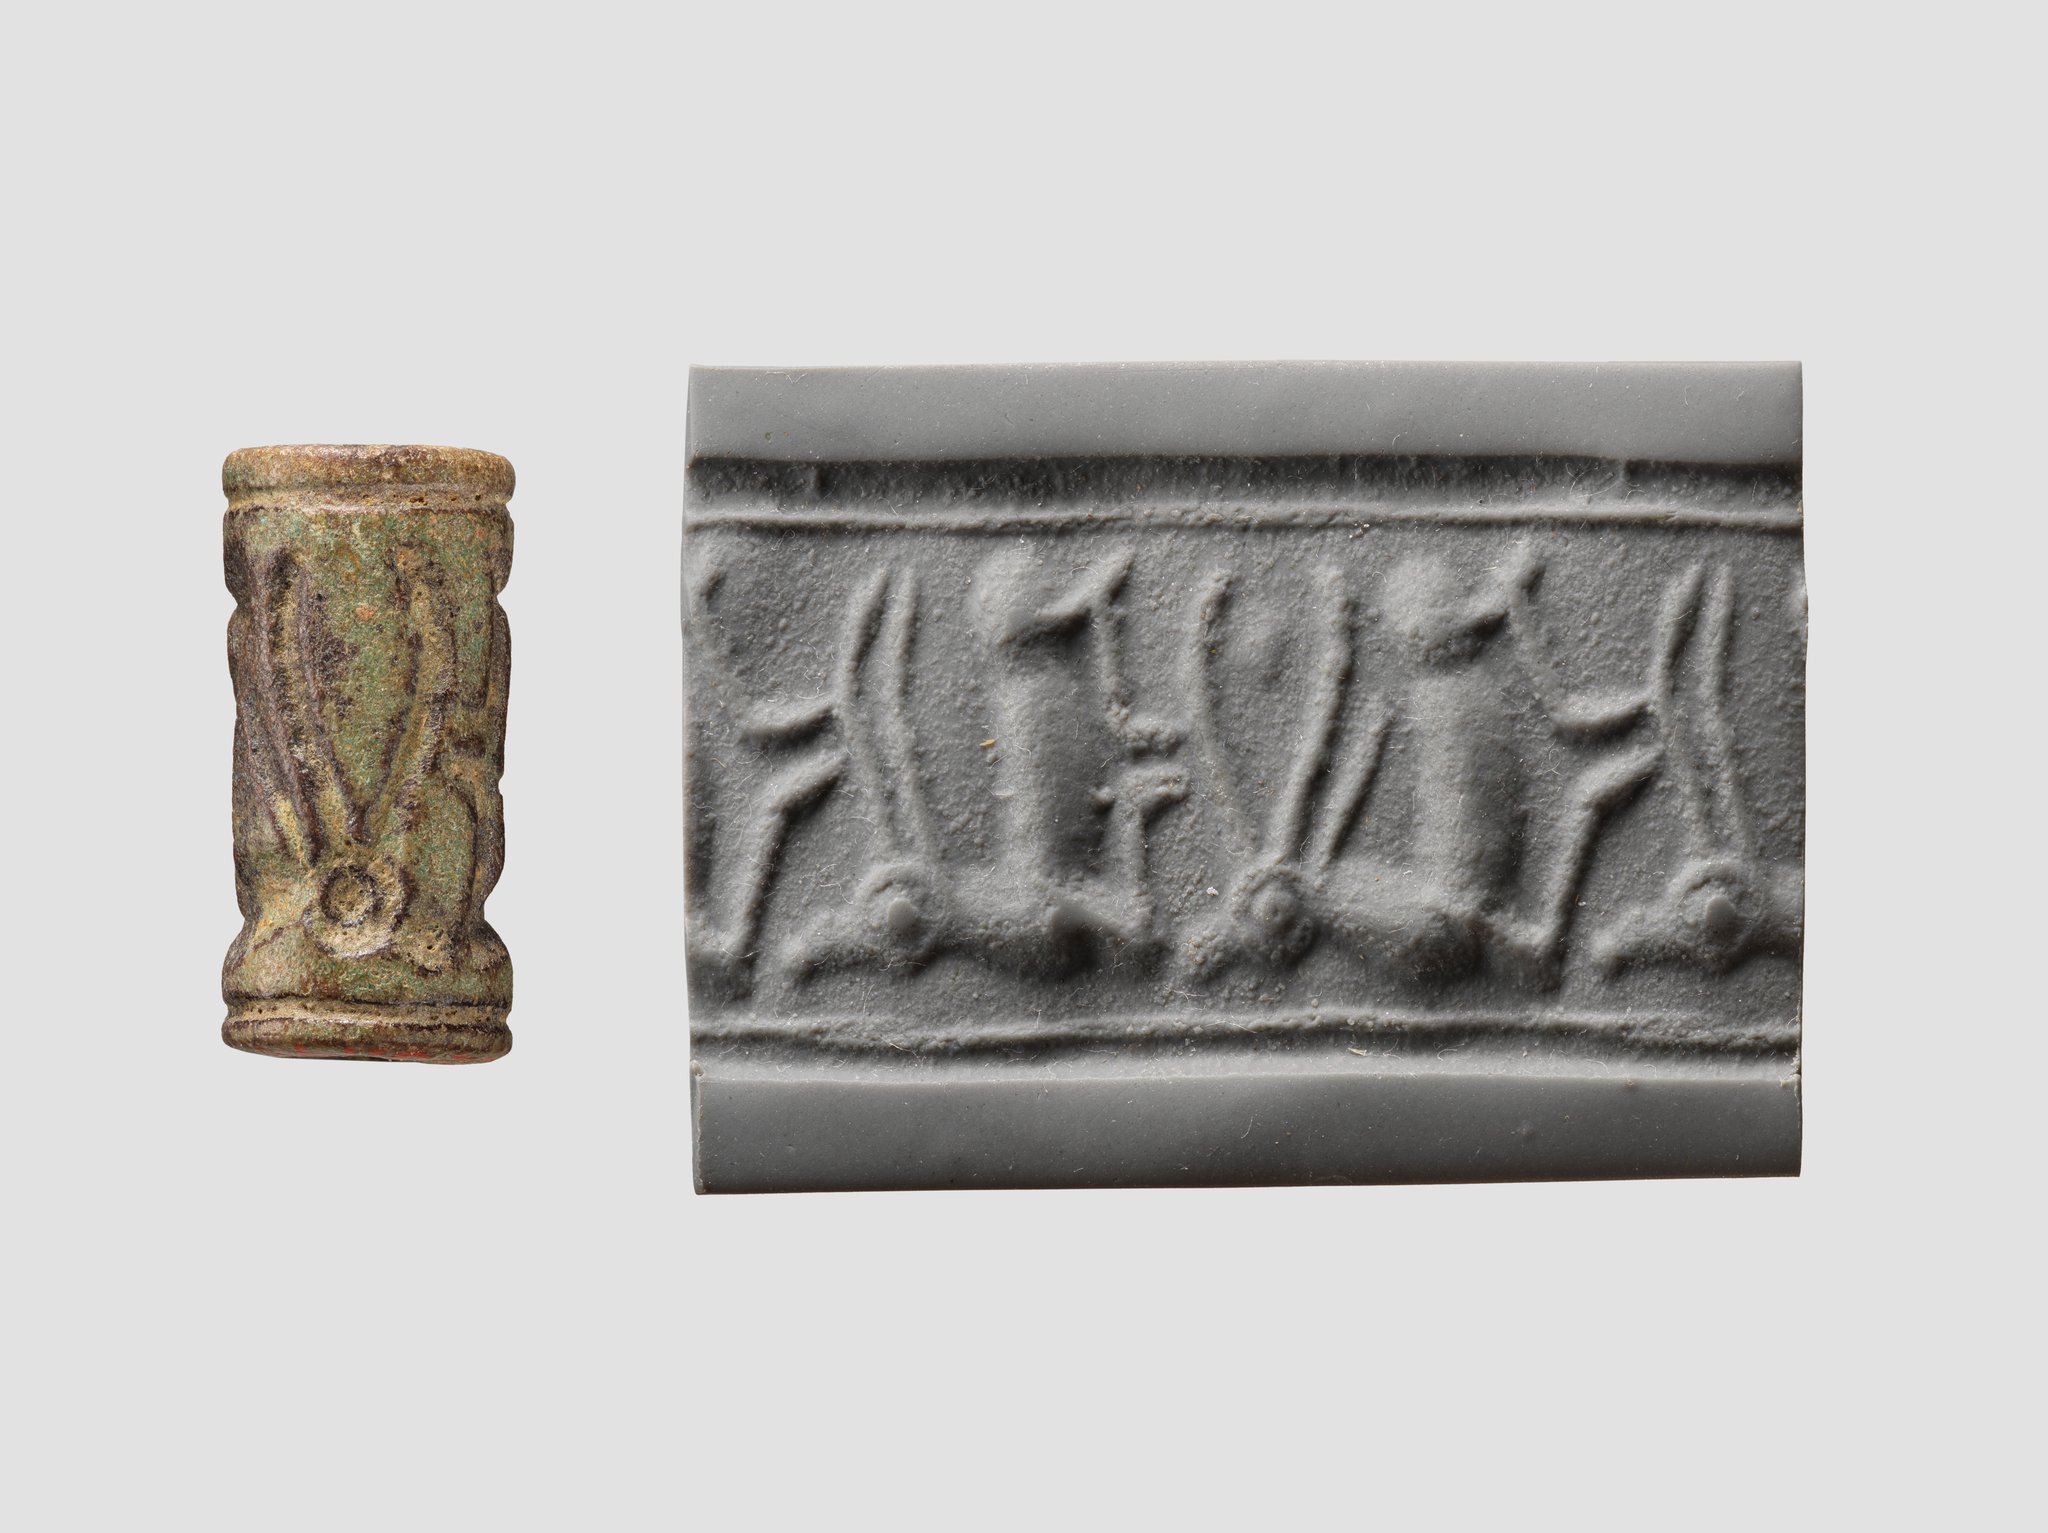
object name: cylinder seal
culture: mitanni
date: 1333-1001 BCE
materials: ceramic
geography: mesopotamia or syria